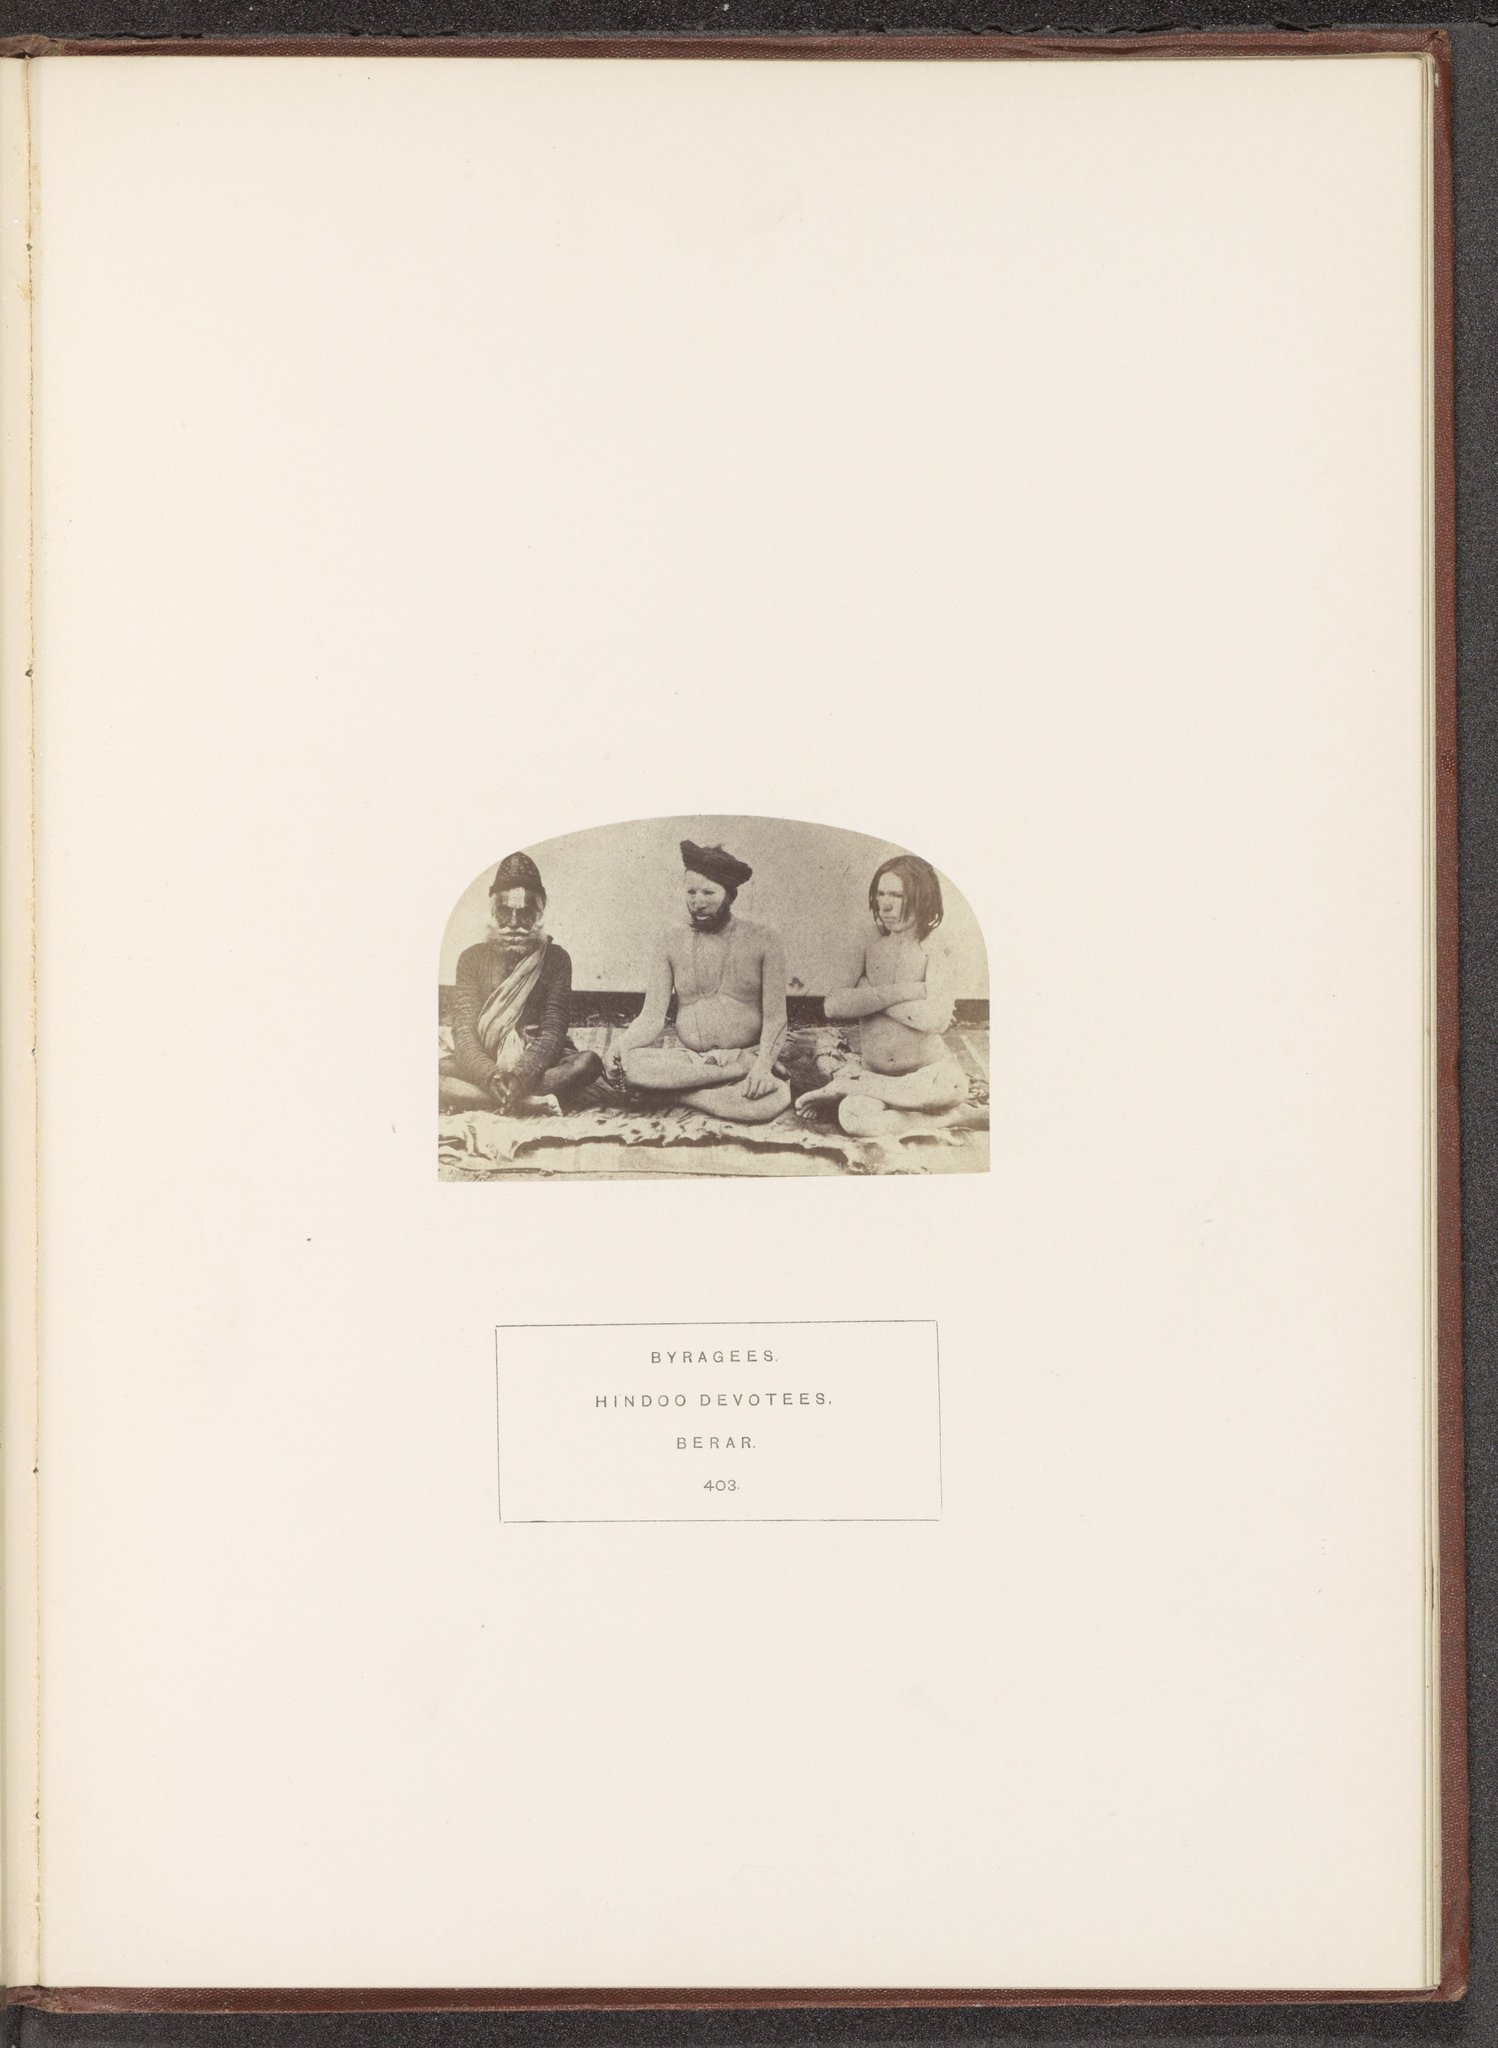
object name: photograph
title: Portrait of three unknown men from the Bairagi community of the former Berar in central India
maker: james mulheran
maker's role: fotograaf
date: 1862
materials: photographic support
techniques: albumen print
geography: berar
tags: asceticism ~ hinduism, buddhism, jainism, human races; peoples; nationalities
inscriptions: number: ‘403.’, inscription: ‘BYRAGEES./ HINDOO DEVOTEES./ BERAR.’